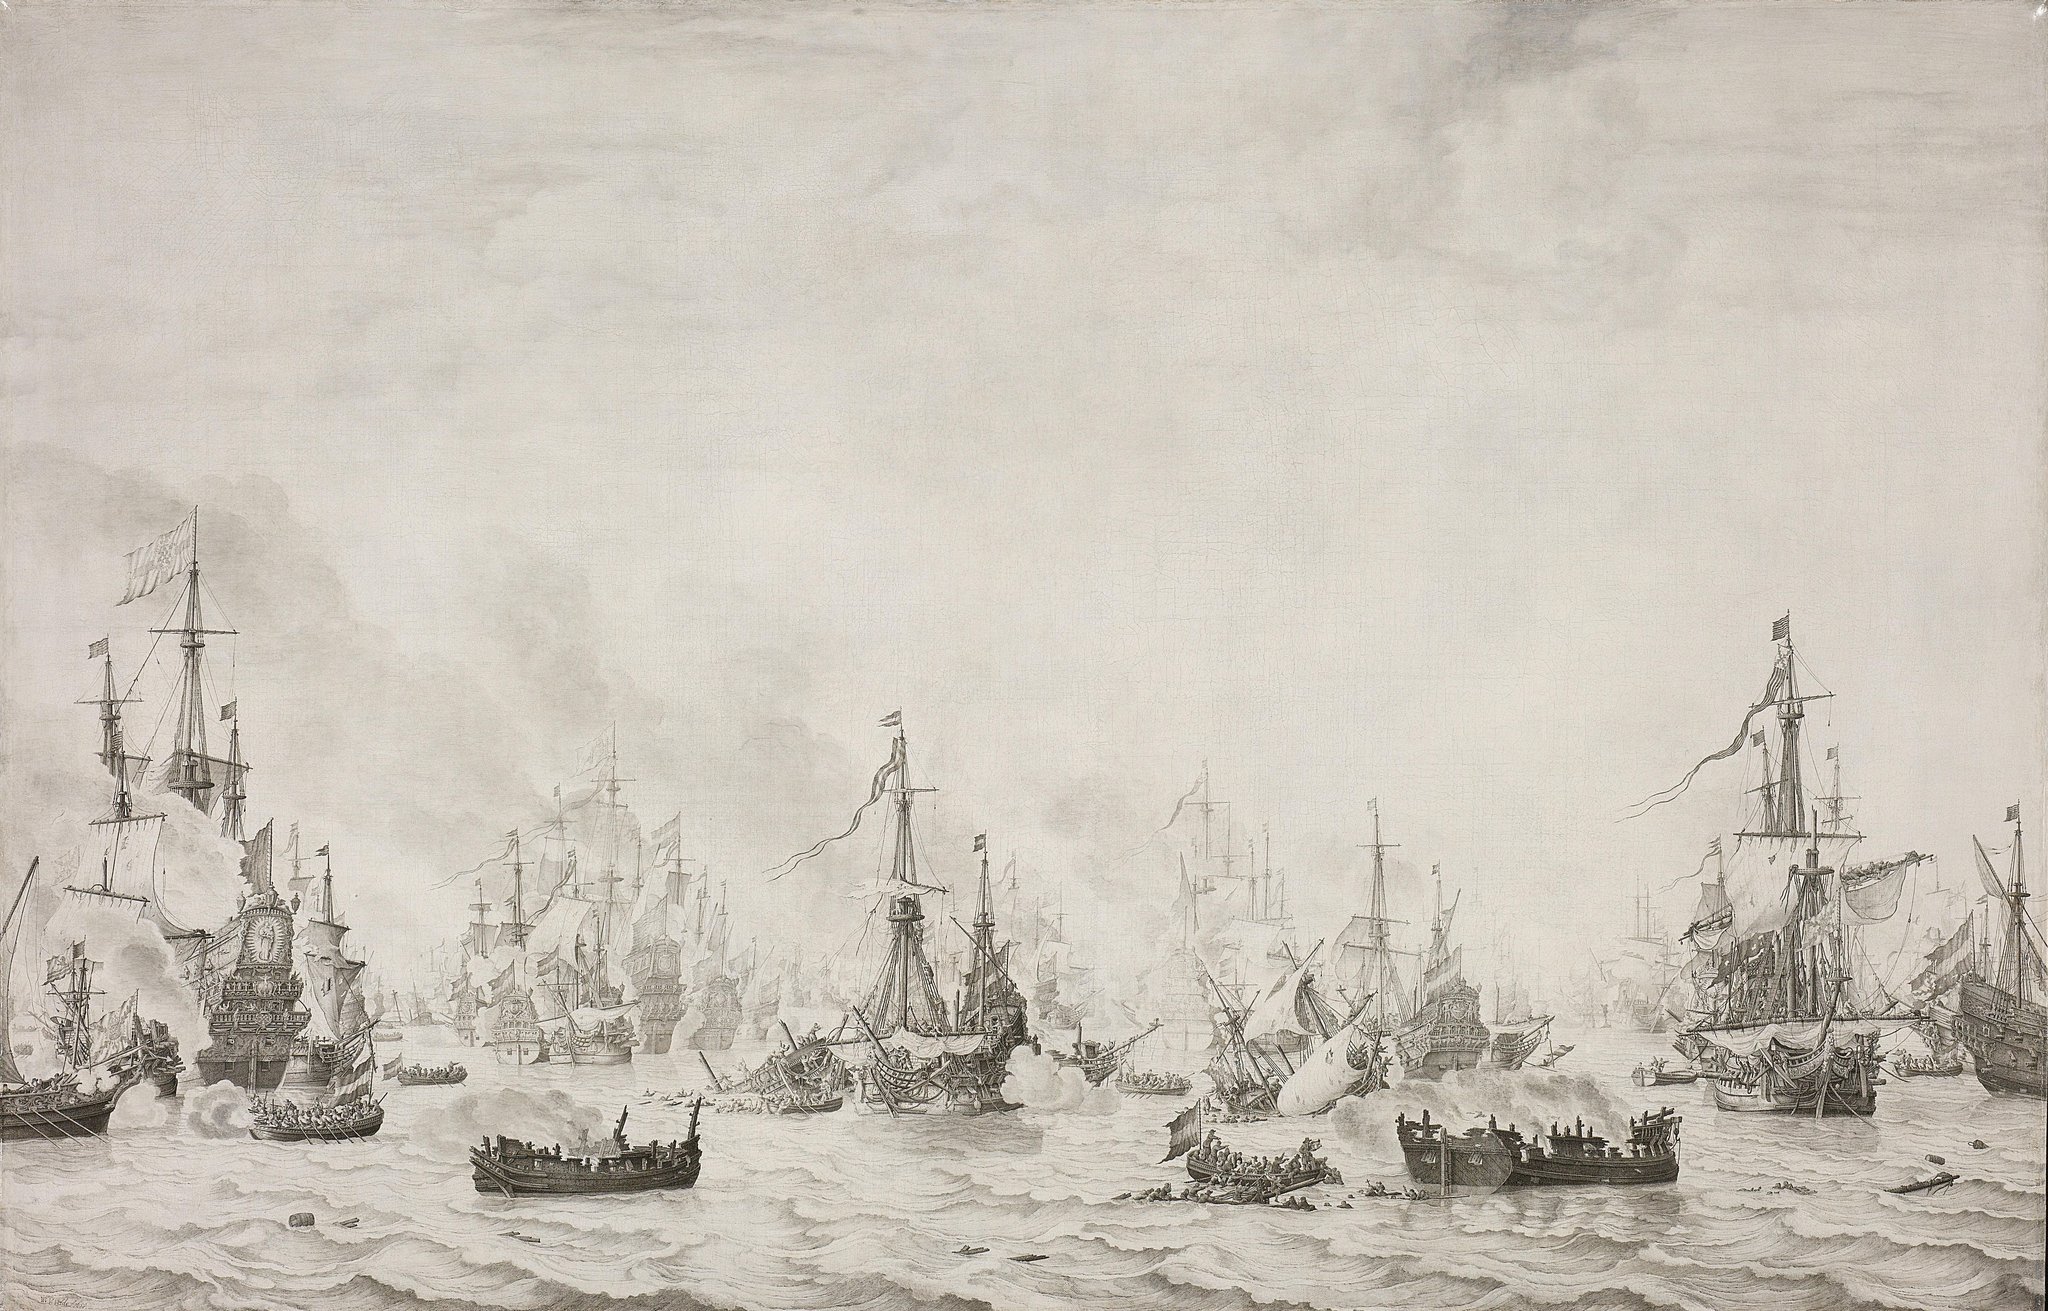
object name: penschildering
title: The Battle of the Downs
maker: willem van de velde (i)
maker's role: draughtsman, painter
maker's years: 1611-1693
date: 1659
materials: canvas, ink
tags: rotterdam, amsterdam, cornelis tromp, brielle, maarten harpertszoon tromp, sailing-ship, sailing-boat, battle (+ sailing-ships), battle of the downs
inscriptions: signature and date: ‘W. v. Velde f. 1659’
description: In 1639 the Spanish attempted to transport troops and supplies to Flanders with a large fleet. The Spanish armada was intercepted in the English Channel by Maerten Harpertsz Tromp, who commanded a much smaller force. His spectacular victory and his capture of the Santa Teresa – the large Spanish warship burning on the left – established the Dutch fleet’s formidable reputation.